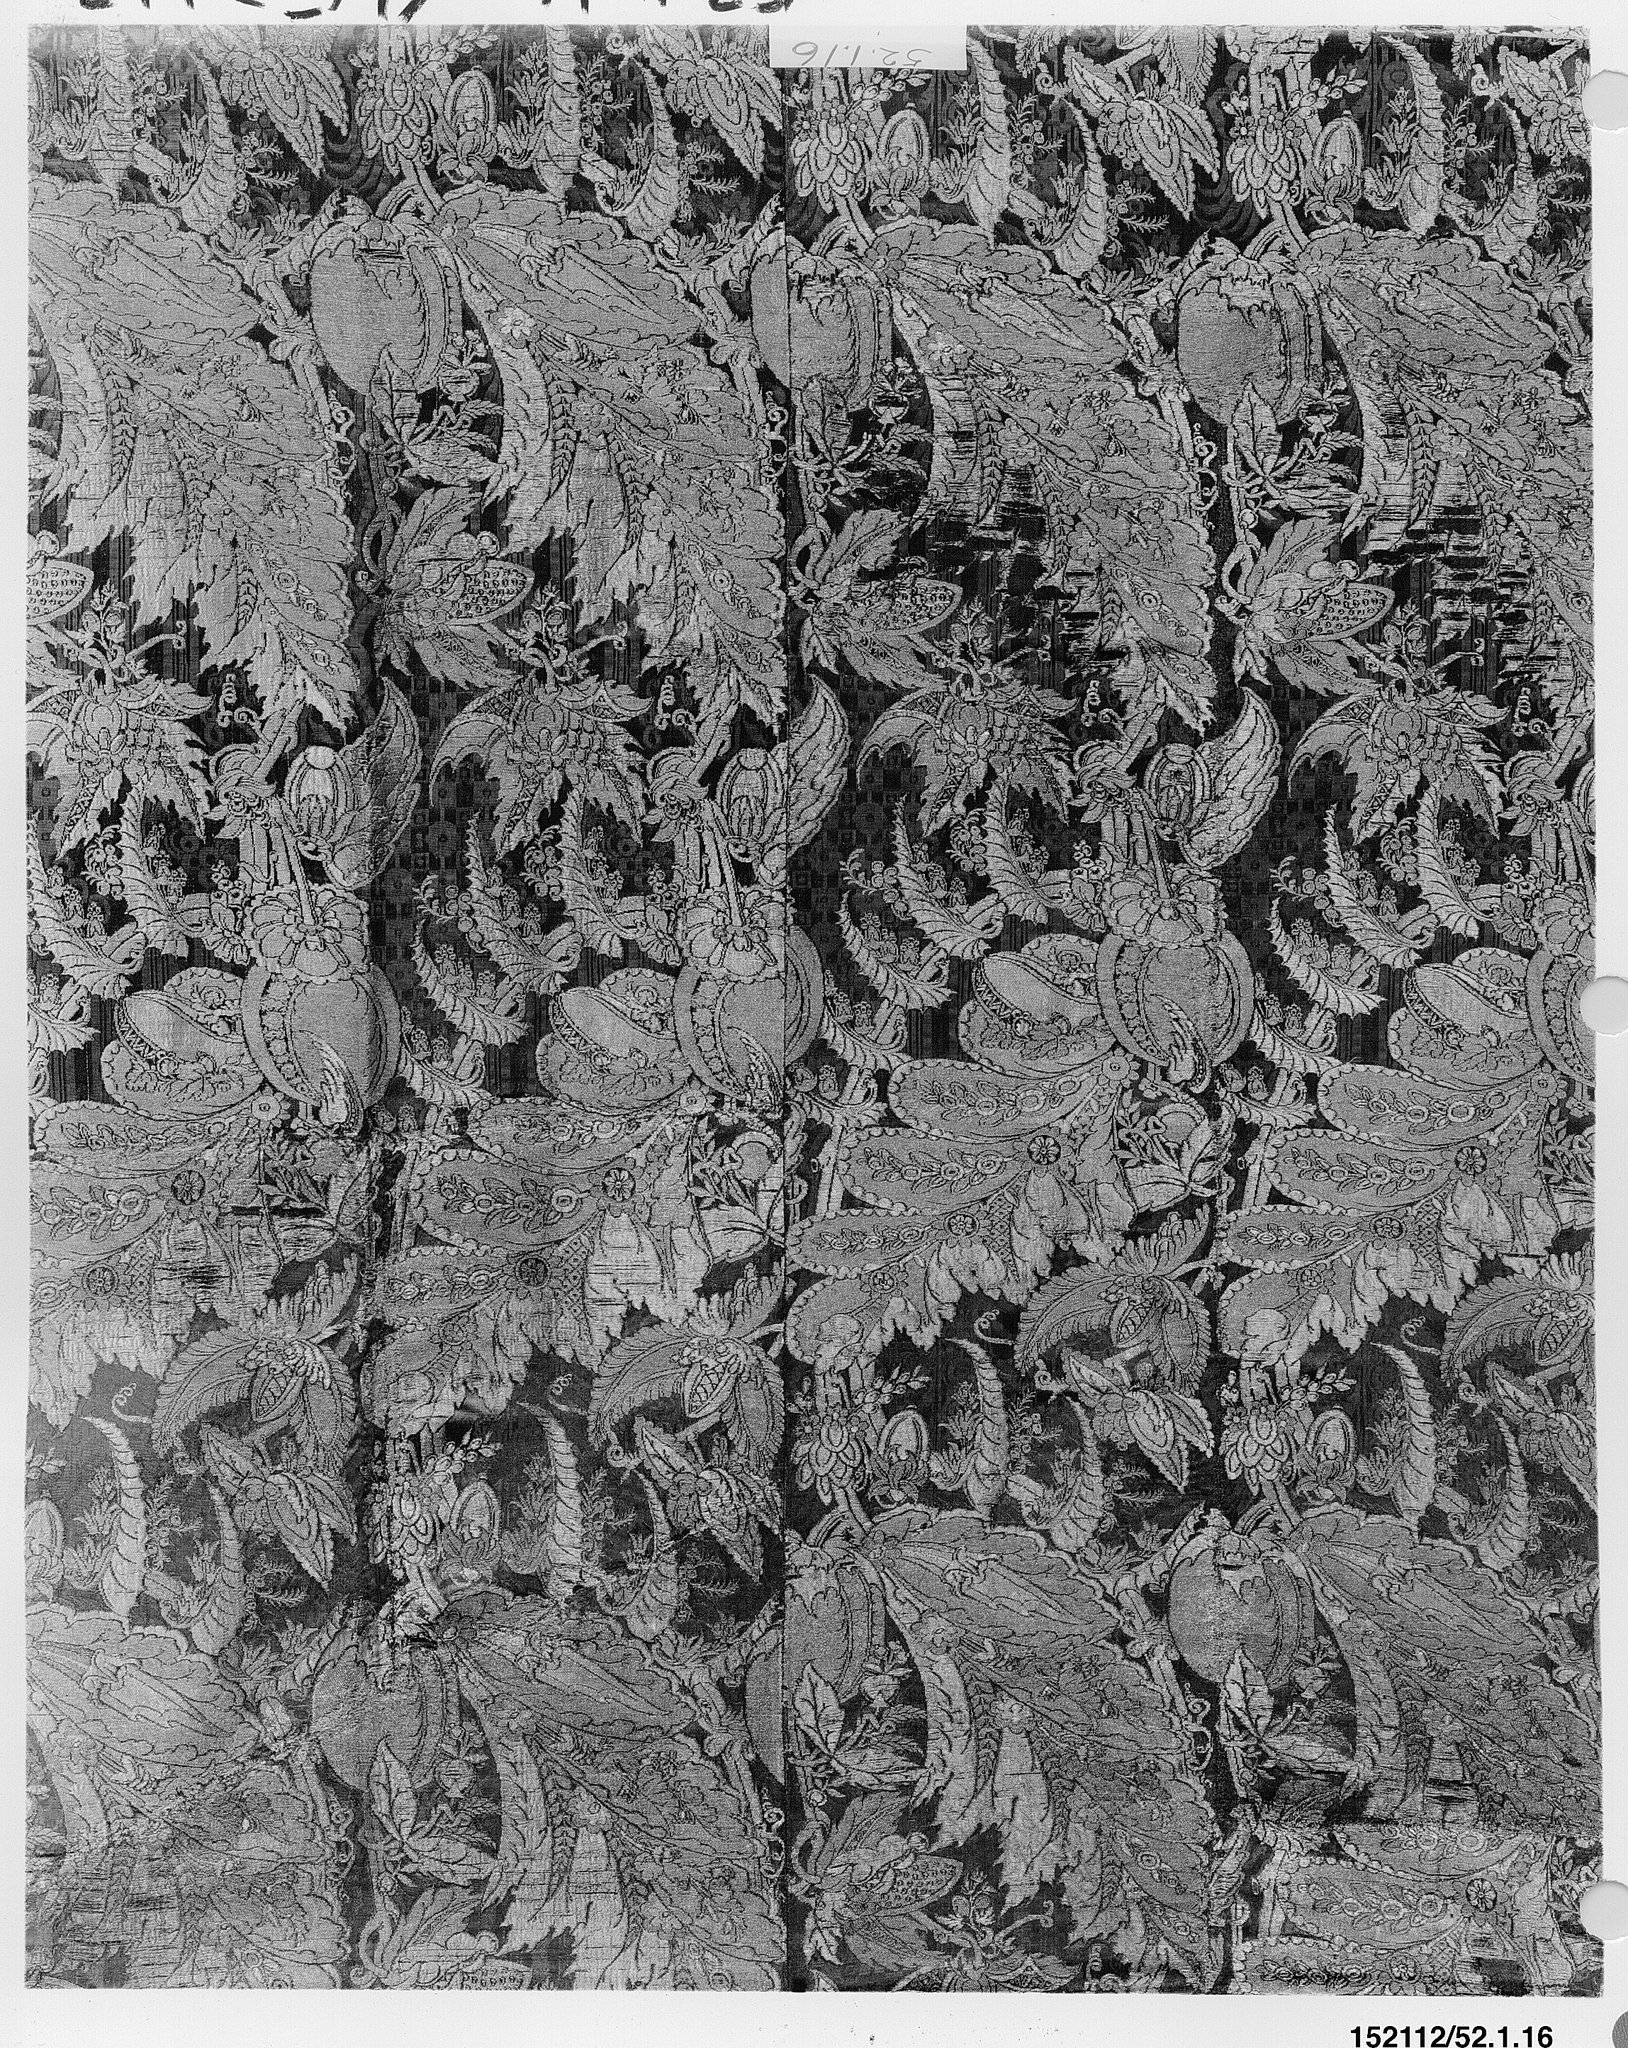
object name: panel or cover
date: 1715-1720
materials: metal thread, silk